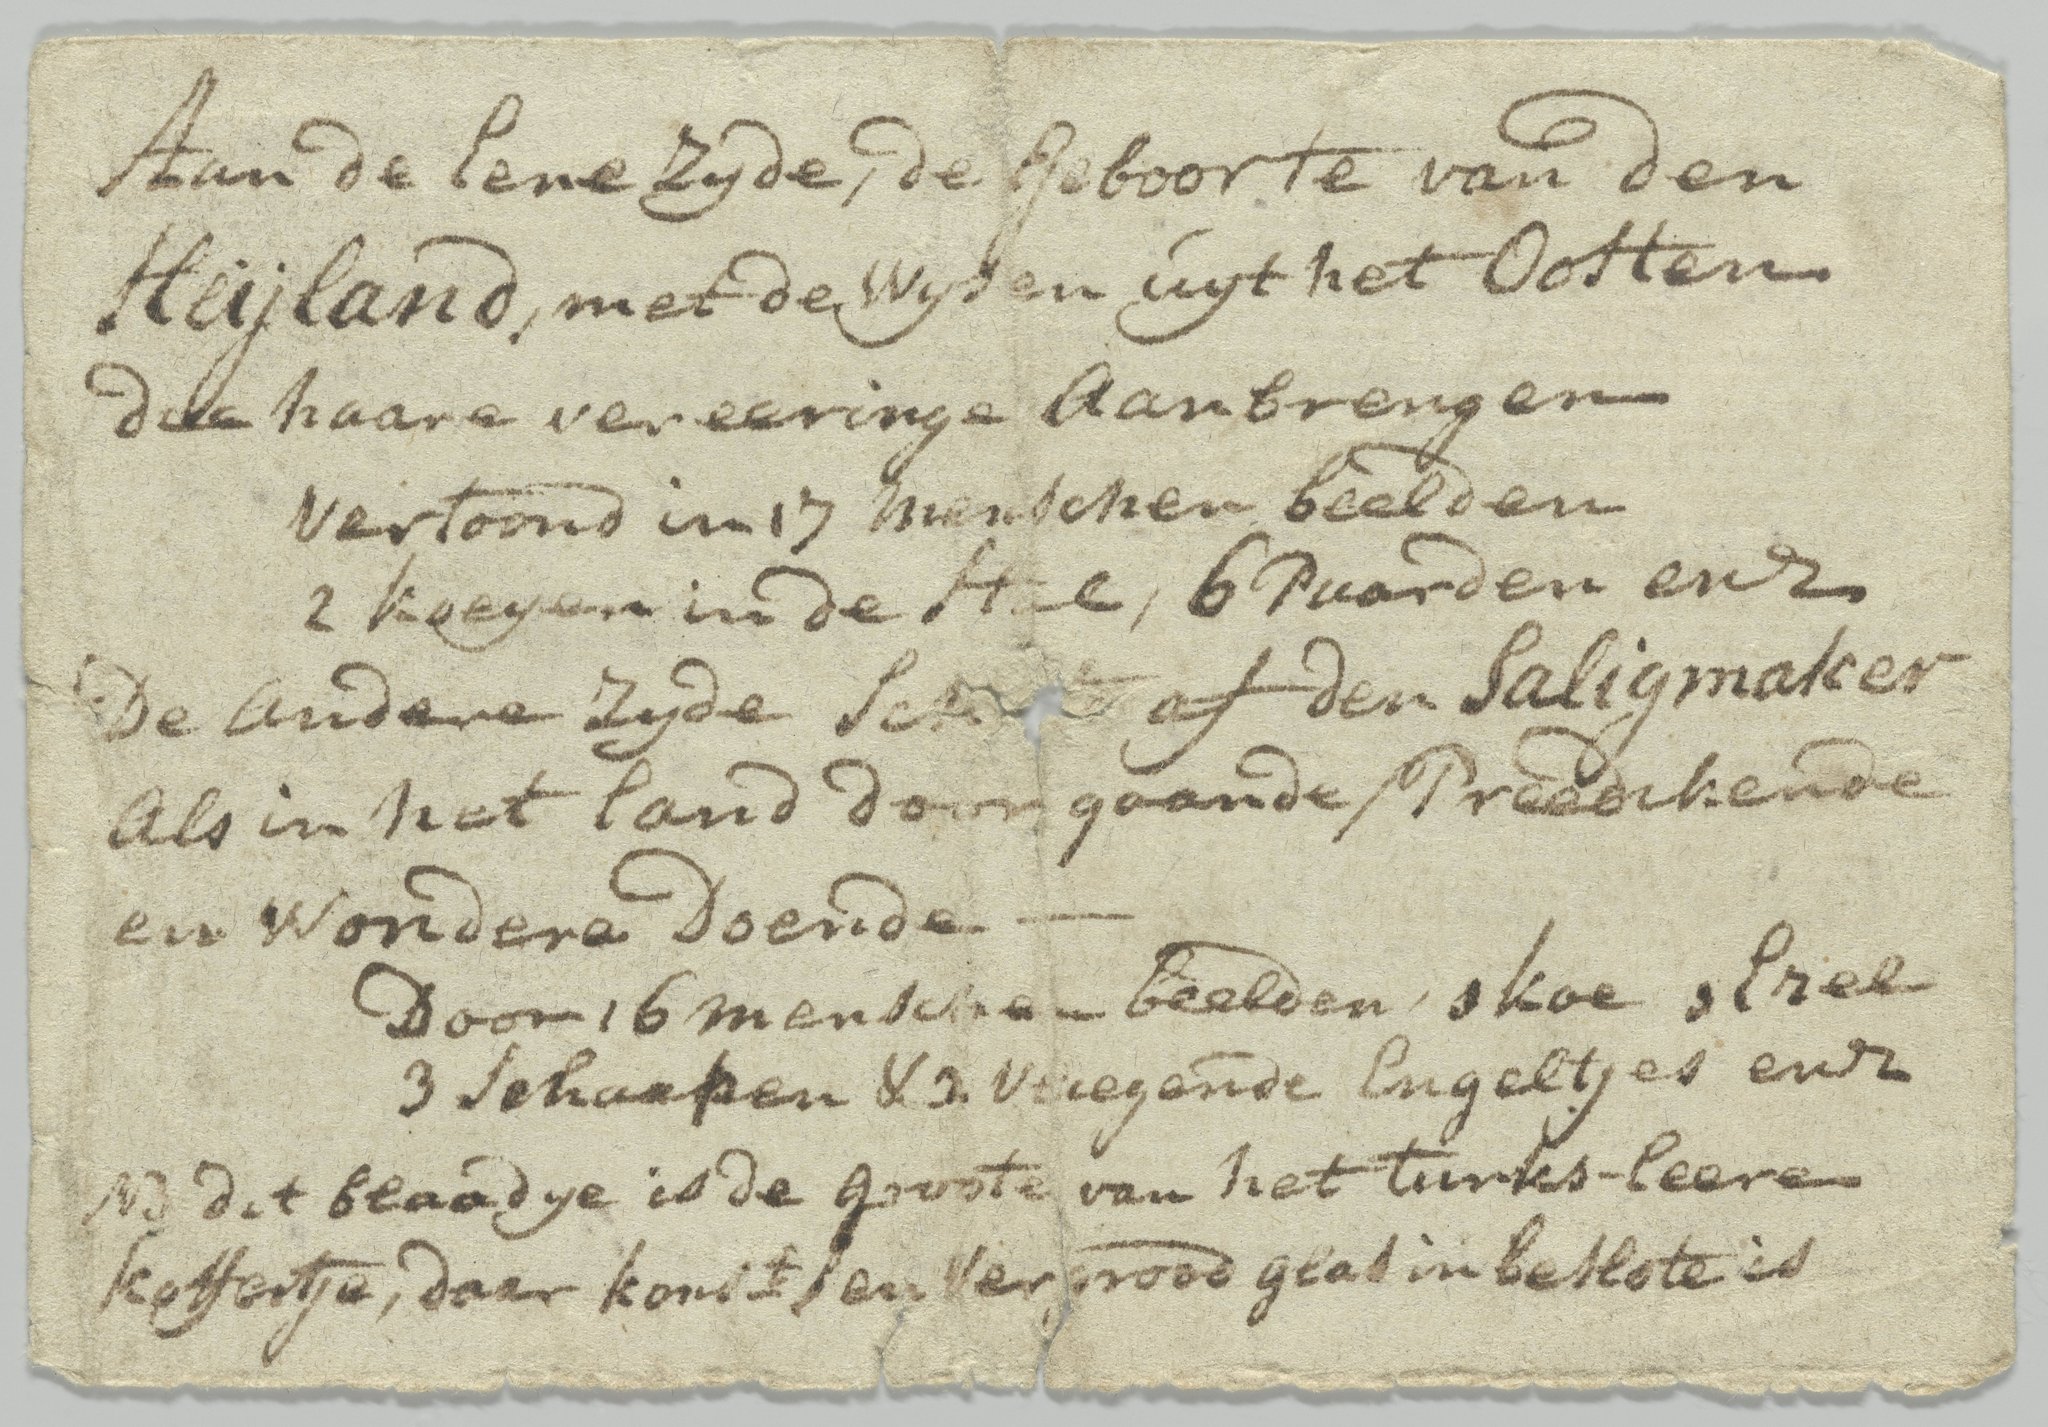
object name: letter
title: Beschrijving behorend bij gebedsnoot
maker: Anonymous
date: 1700-1799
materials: paper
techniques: writing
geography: low countries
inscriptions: inscription: ‘Dit zeer konstig silver balletje, het wek uyt twee delen bestaat, in welk een aller uytmuntende teekening, uyt gesneede houtwerk te vinden is en in zijn ronte en holligheid, niet grooter is als 3 1/2 duym in zijn bewerking vind men ___ Aan Deze schrap [____] is 3 1/2 Duym.’, inscription: ‘Aan de eene zijde, de geboorte van den Heijland, met de wijzen uit het Oosten die haare vereeringen aanbrengen en vertoond in 17 menschen beelden, 2 koeyen in de stal, 6 paarden enzo. De andere zijde [...] af der saligemaker als in het land doorgaande, preedikende en wondere doende. Door 16 menschen beelden, 3 koe, 3 ezel, 3 schaapen & 3 verijzende engeltjes enz. Na dit blaadje is de groote van het turks-leeren koffertje, daar komt [....] is’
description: Handgeschreven beschrijving die vertelt hoe klein de noot is en wat erin te zien is.